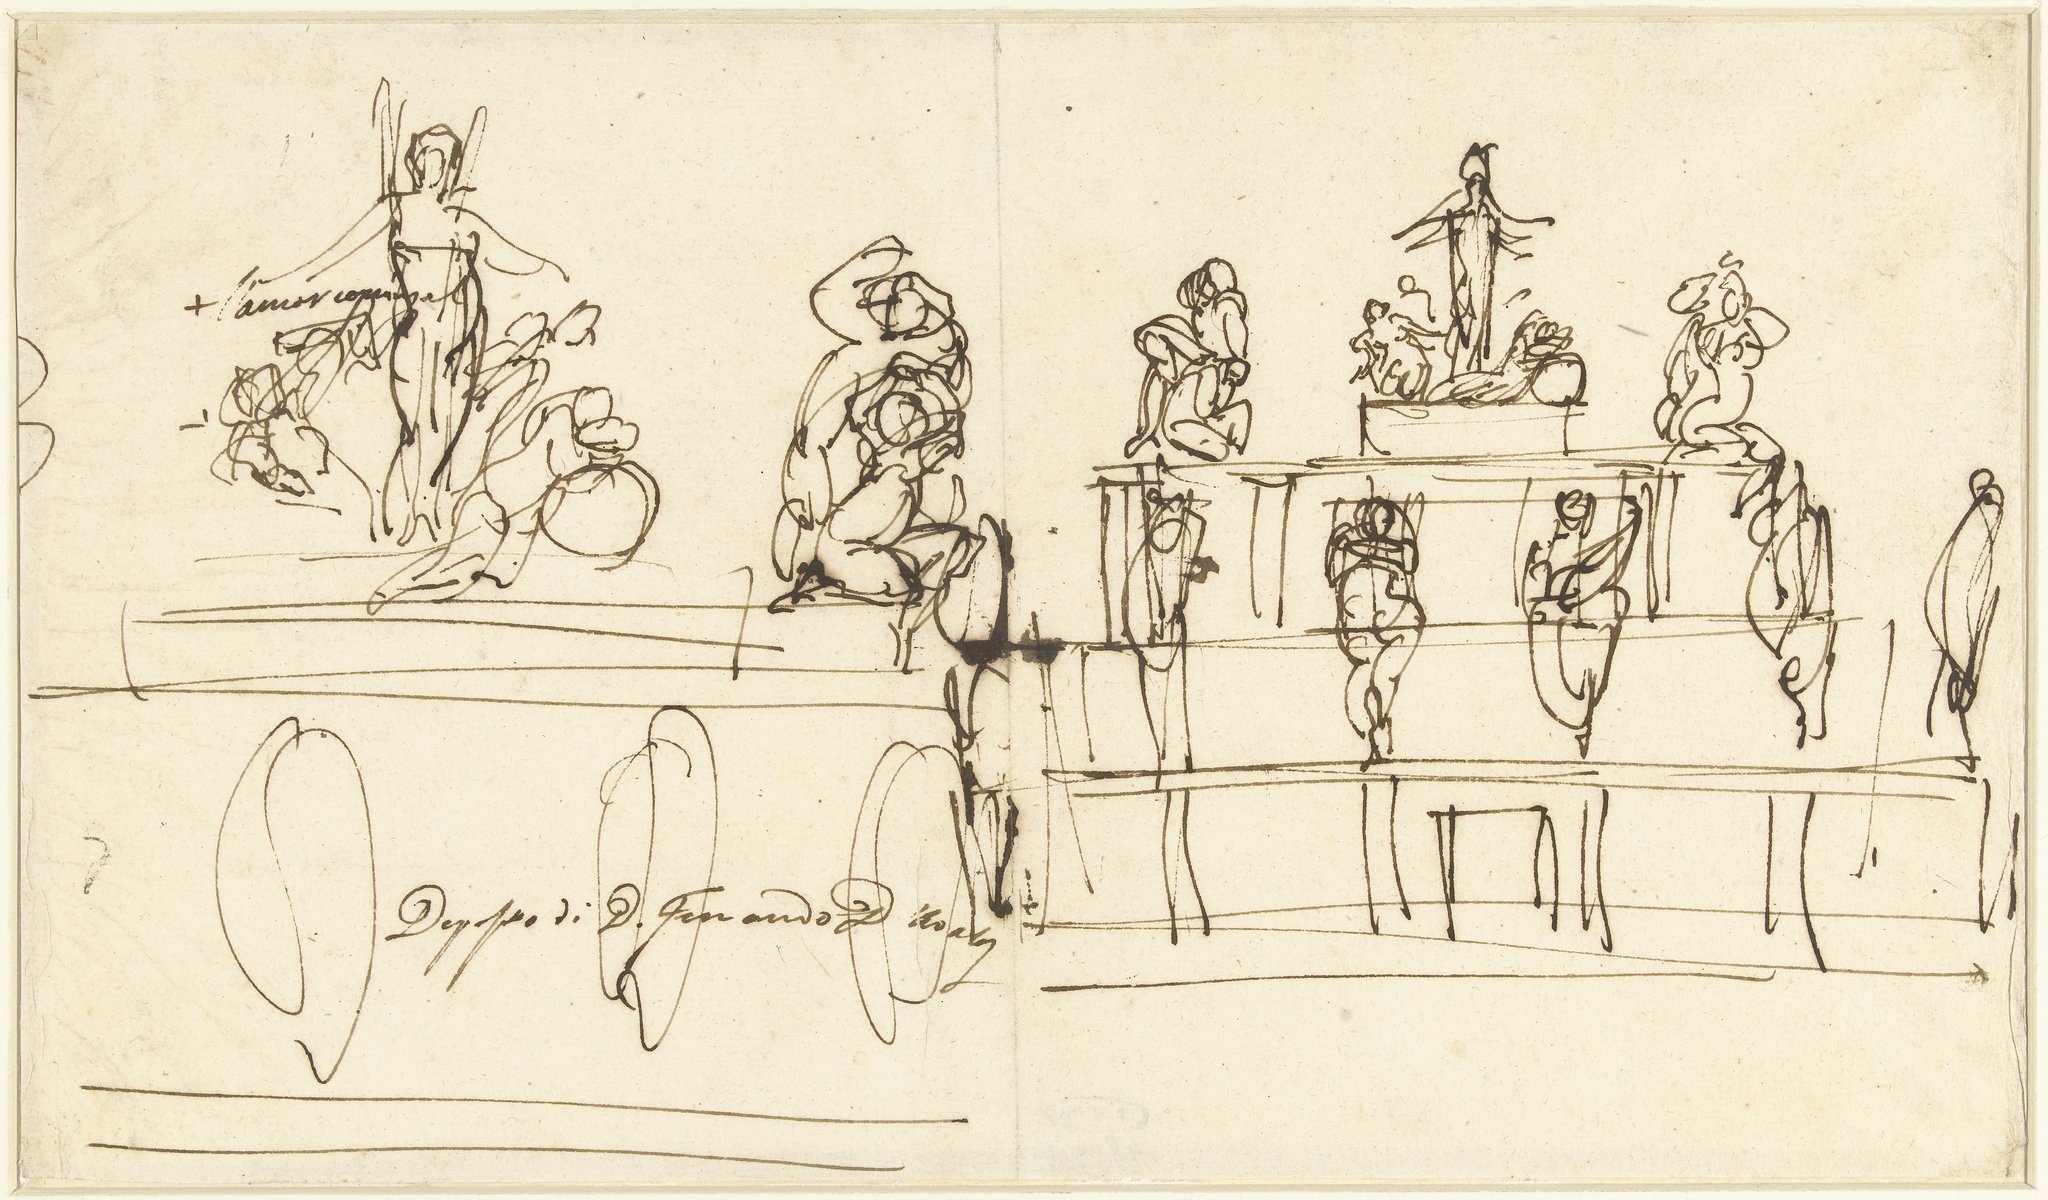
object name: drawing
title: Ontwerp voor het grafmonument van Fernando d'Avalos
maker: ferdinando fuga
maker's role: draughtsman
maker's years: 1699-1781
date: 1709-1781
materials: ink, paper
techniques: pen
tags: spain, historical persons, grave-building, monumental tomb